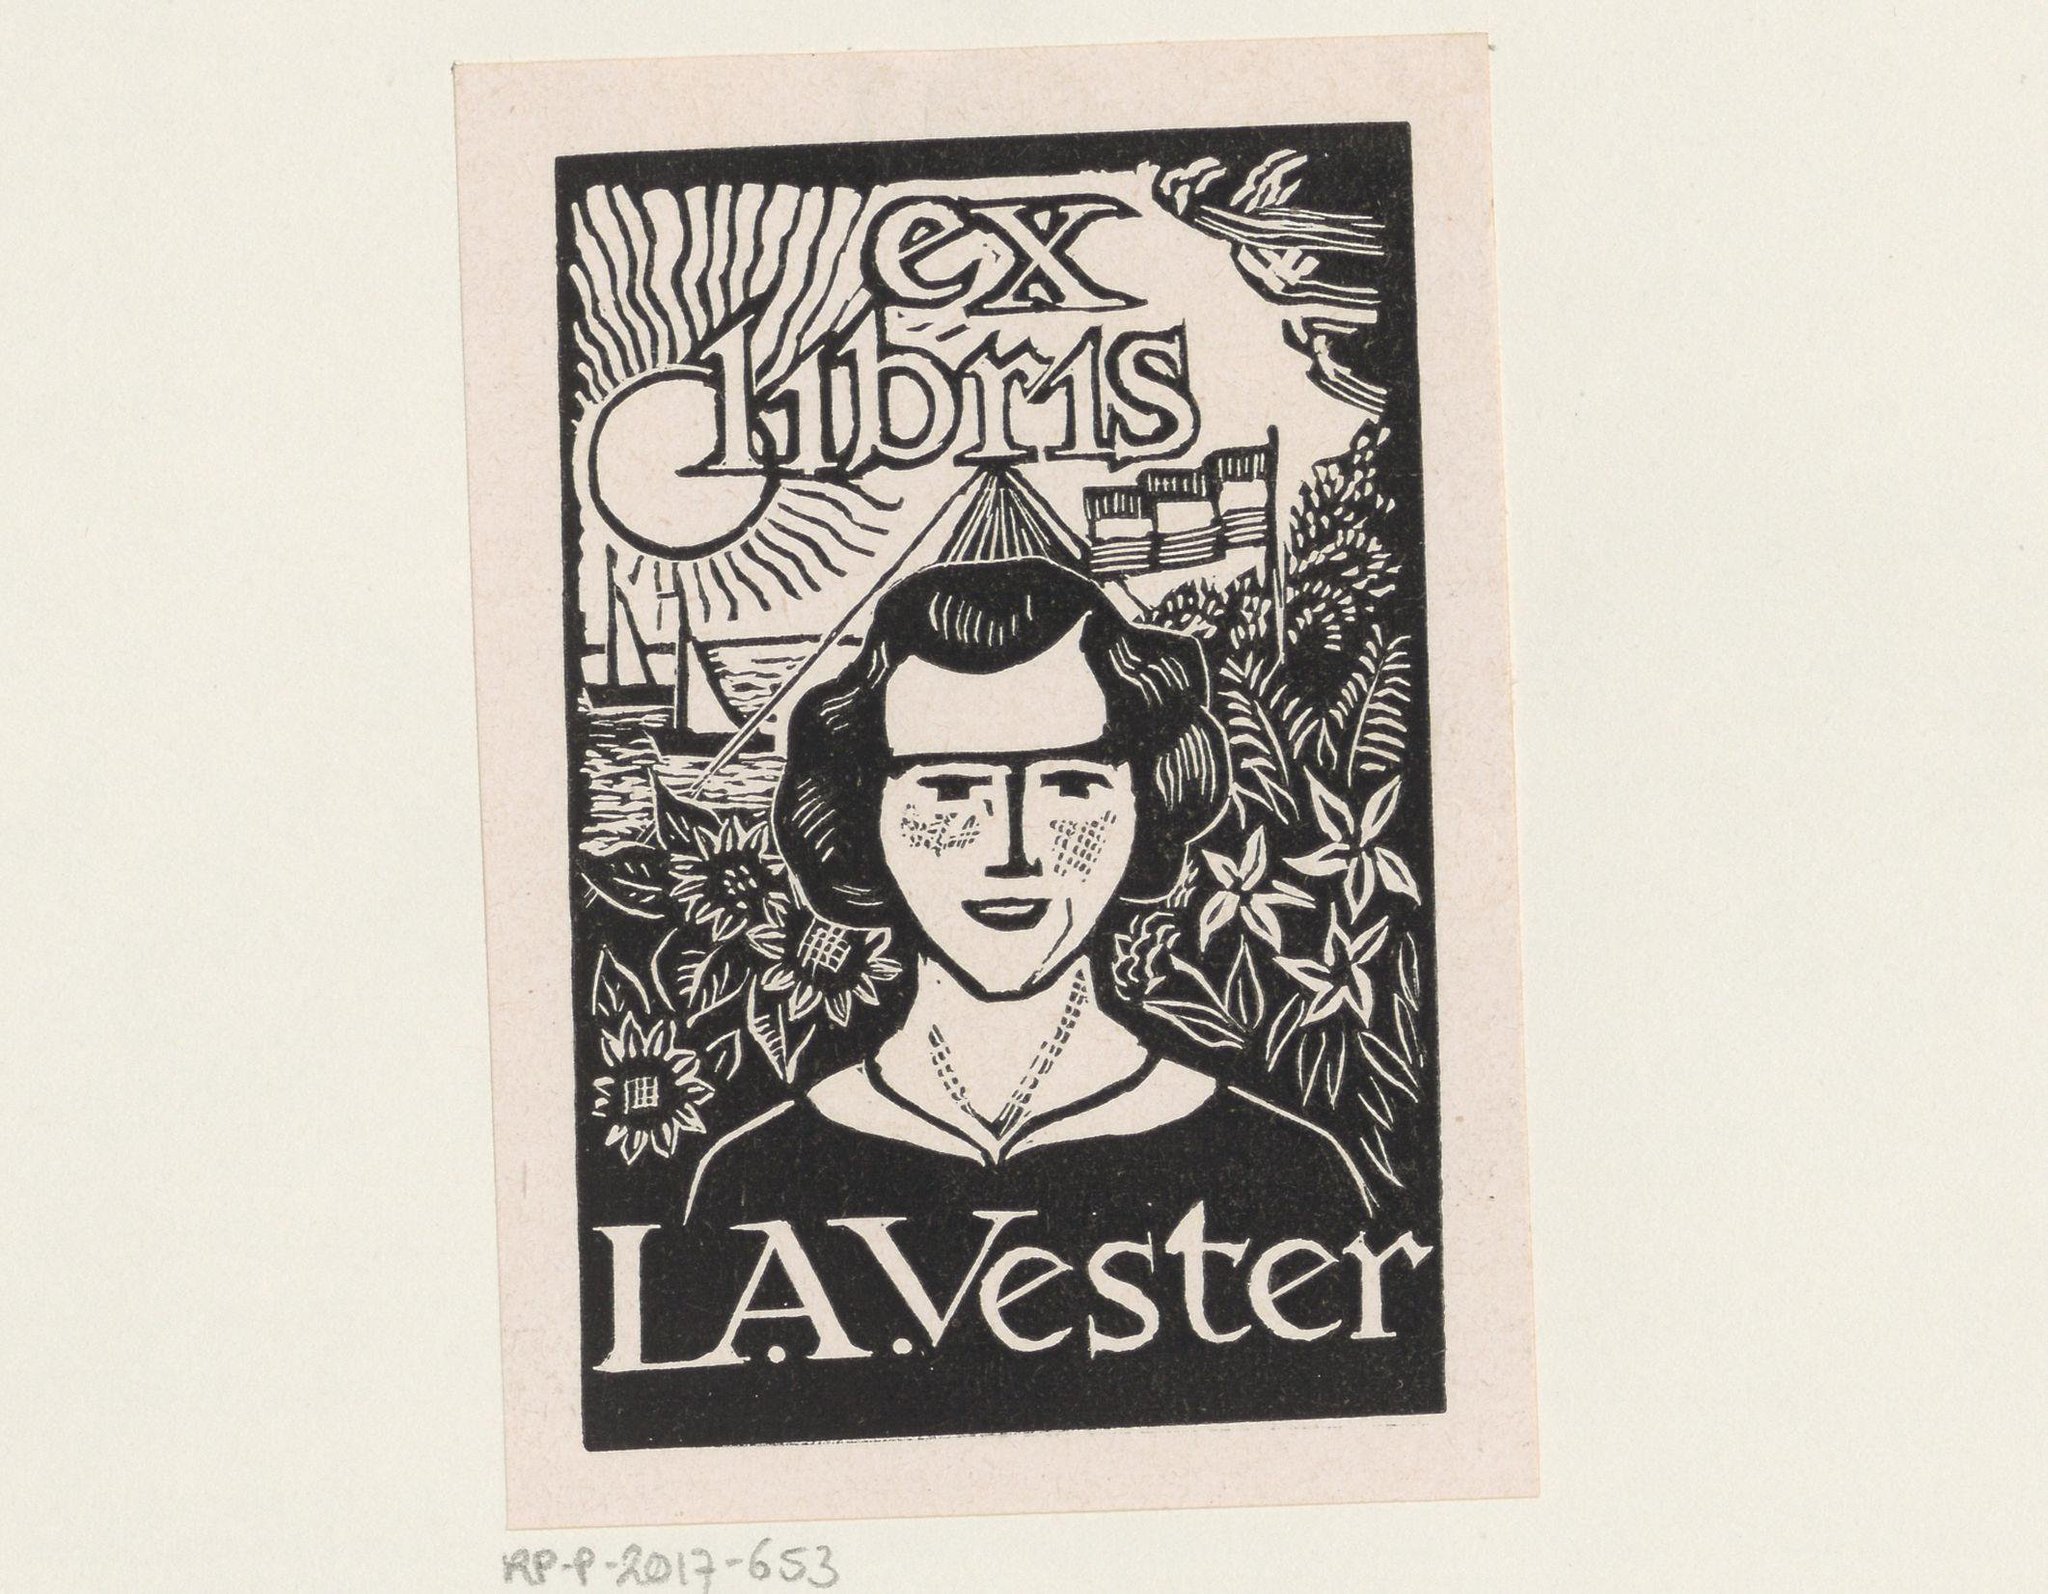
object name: bookplate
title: Ex libris van L.A. Verster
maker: johan van hell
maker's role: print maker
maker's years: 1889-1952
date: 1943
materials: paper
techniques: woodcut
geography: amsterdam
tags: adult woman, sailing-ship, sailing-boat, flag, colours (as symbol of the state, etc.)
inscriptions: signature and date: ‘Joh. v. Hell / 1943 / Amsterdam’